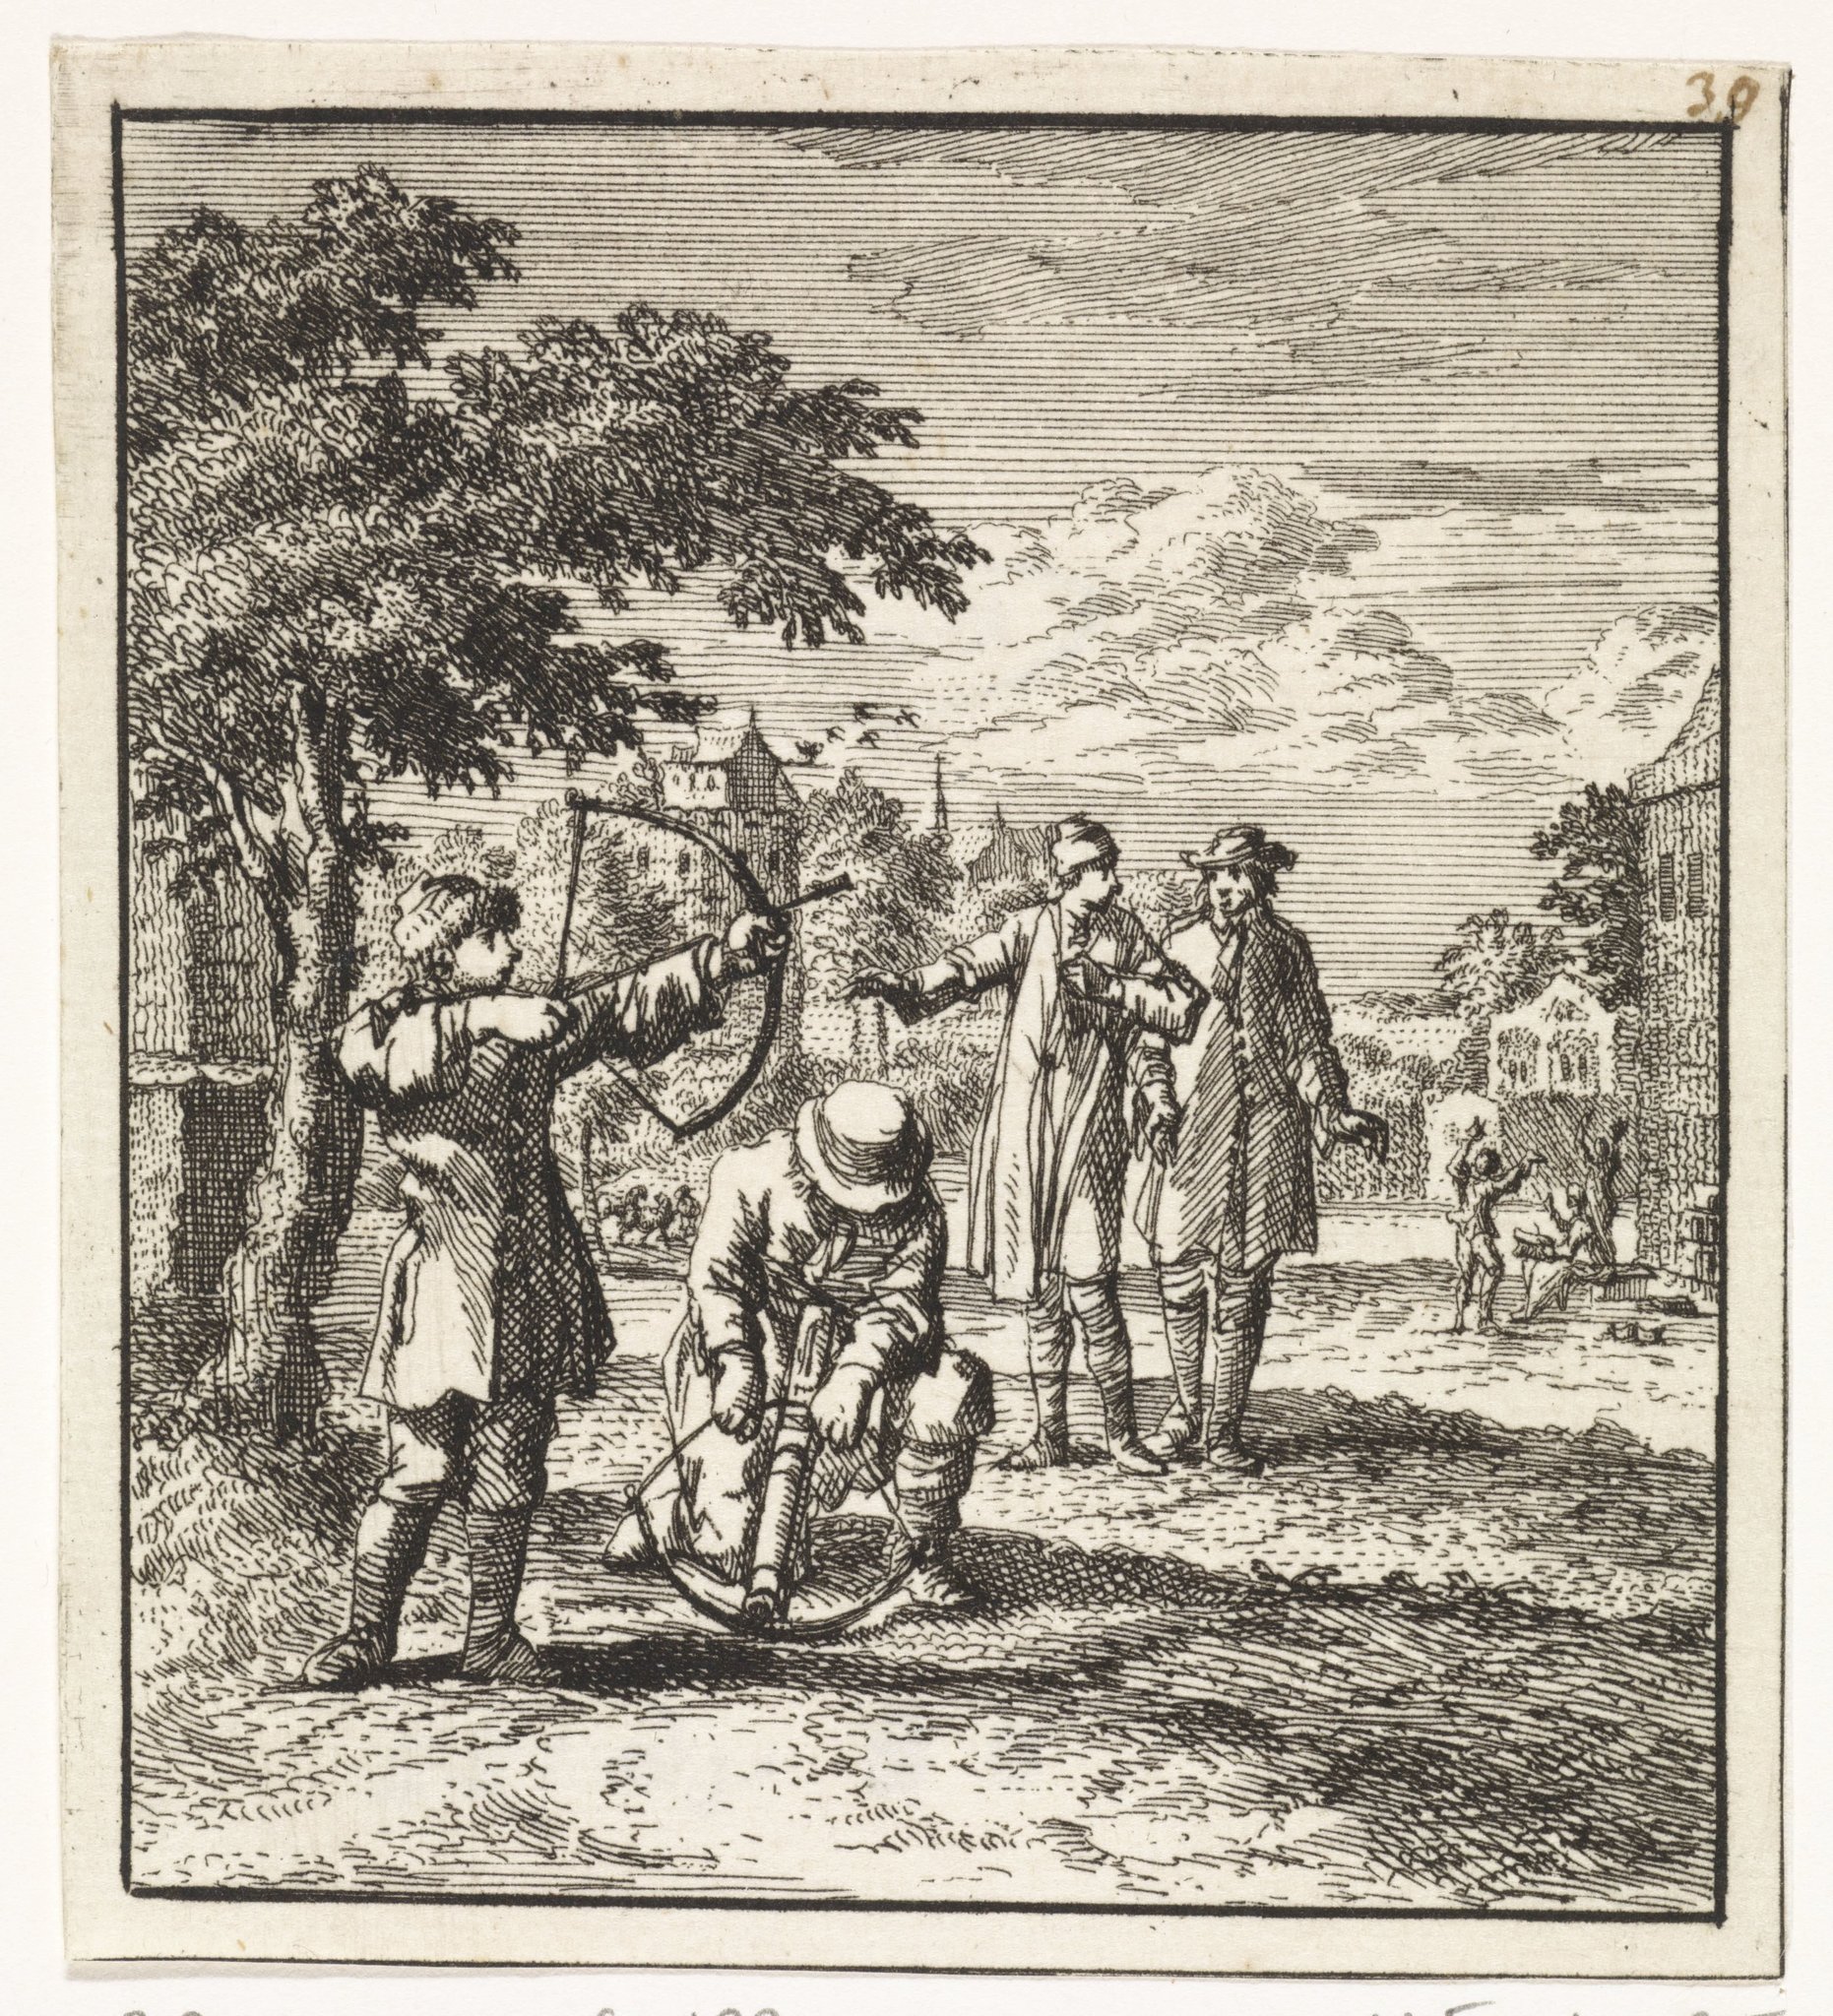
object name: print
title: Boogschieten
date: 1712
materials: paper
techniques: etching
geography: amsterdam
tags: shooting with bow and arrow, archery (~ games of skill)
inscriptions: collector's mark: Lugt 2228, number: ‘39’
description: Proefdruk van illustratie uit: Luyken, Jan. Des menschen begin, midden en einde. Amsterdam: Wed. Pieter Arentsz II en Cornelis van der Sys, 1712, p. 81.